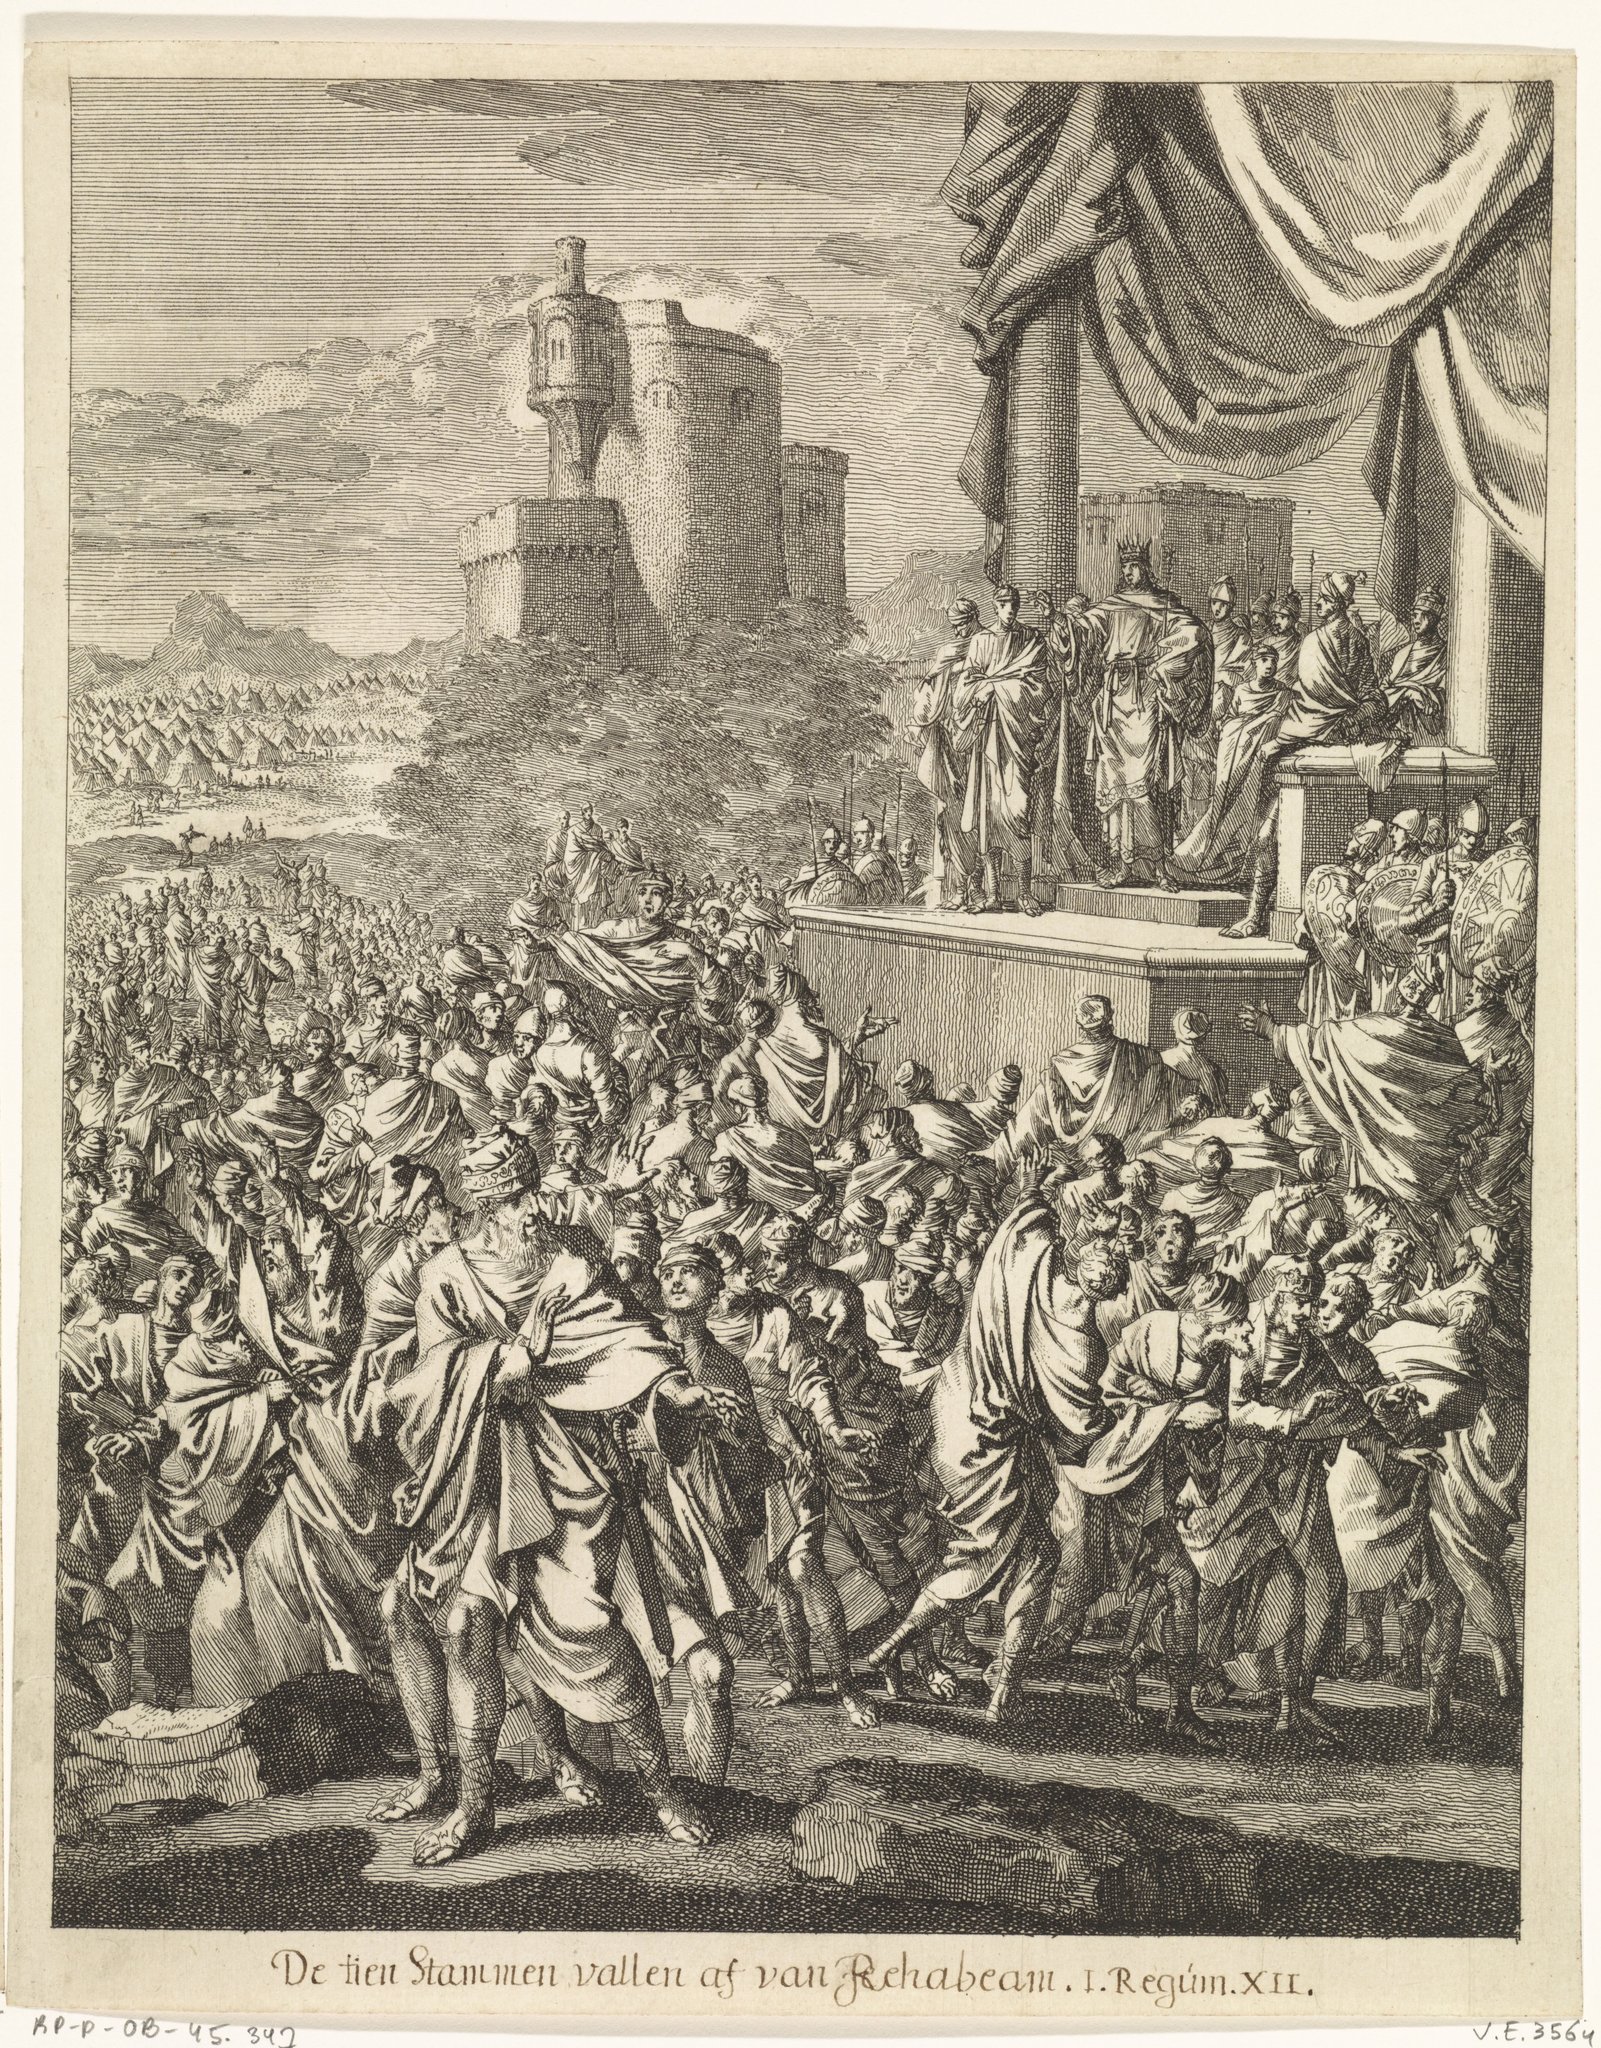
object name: print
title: Rechabeam verwerpt de raad der oudsten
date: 1708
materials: paper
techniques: etching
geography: amsterdam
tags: rehoboam's insulting reply: forsaking the warning of the wise old counsel- lors but following the young advisers' opinion, rehoboam not only refuses to lessen the taxes, but increases them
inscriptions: collector's mark: Lugt 2228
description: Proefdruk van een prent welke is opgenomen als illustratie in: Historiae Celebriores Veteris Testamenti. Christoph Weigel, 1708.